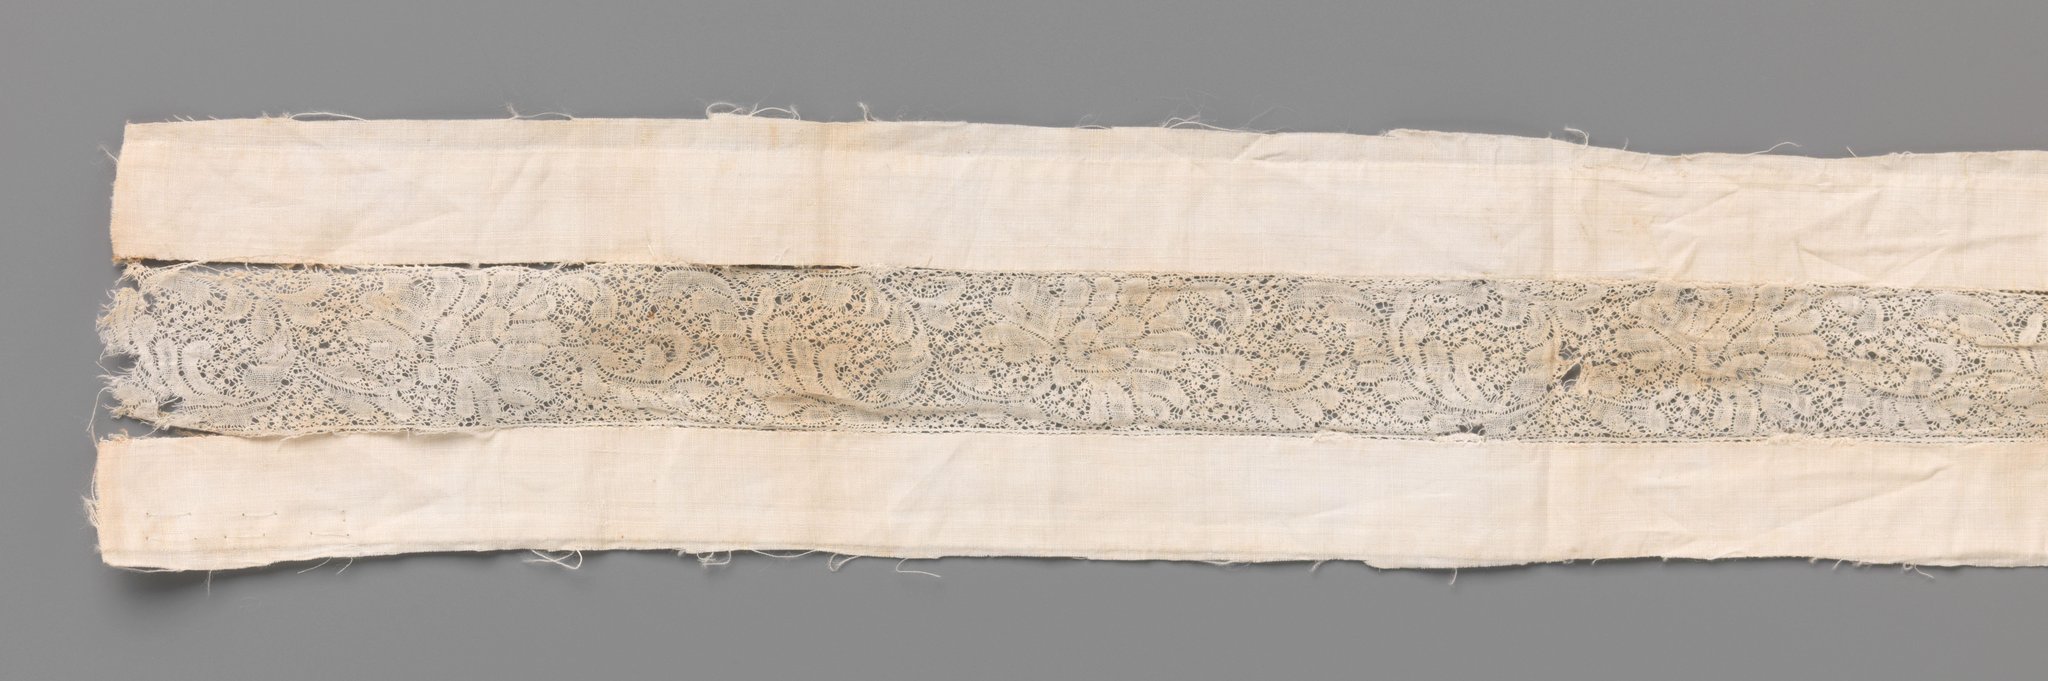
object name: strip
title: Tussenzetsel van kloskant met anjer en cirkelvormend gevederd blad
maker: Anonymous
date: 1740-1760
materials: linen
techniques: lace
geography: binche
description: Tussenzetsel van naturelkleurige kloskant, Binche-kant. Het zich herhalende en doorlopende patroon bestaat uit een schuinliggende anjer aan een gebogen stengel met gevederde bladeren. De bladeren vormen een cirkel. De motieven zijn met elkaar verbonden door een siergrond, een sneeuwvlokkengrond. De motieven zijn gemaakt in linnenslag met opengewerkte randjes. De lange zijden zijn recht afgewerkt. De strook is uit een linnen sloop geknipt, langs beide lange zijden loopt nog een rand van het linnen, het stiksel is deels losgelaten.